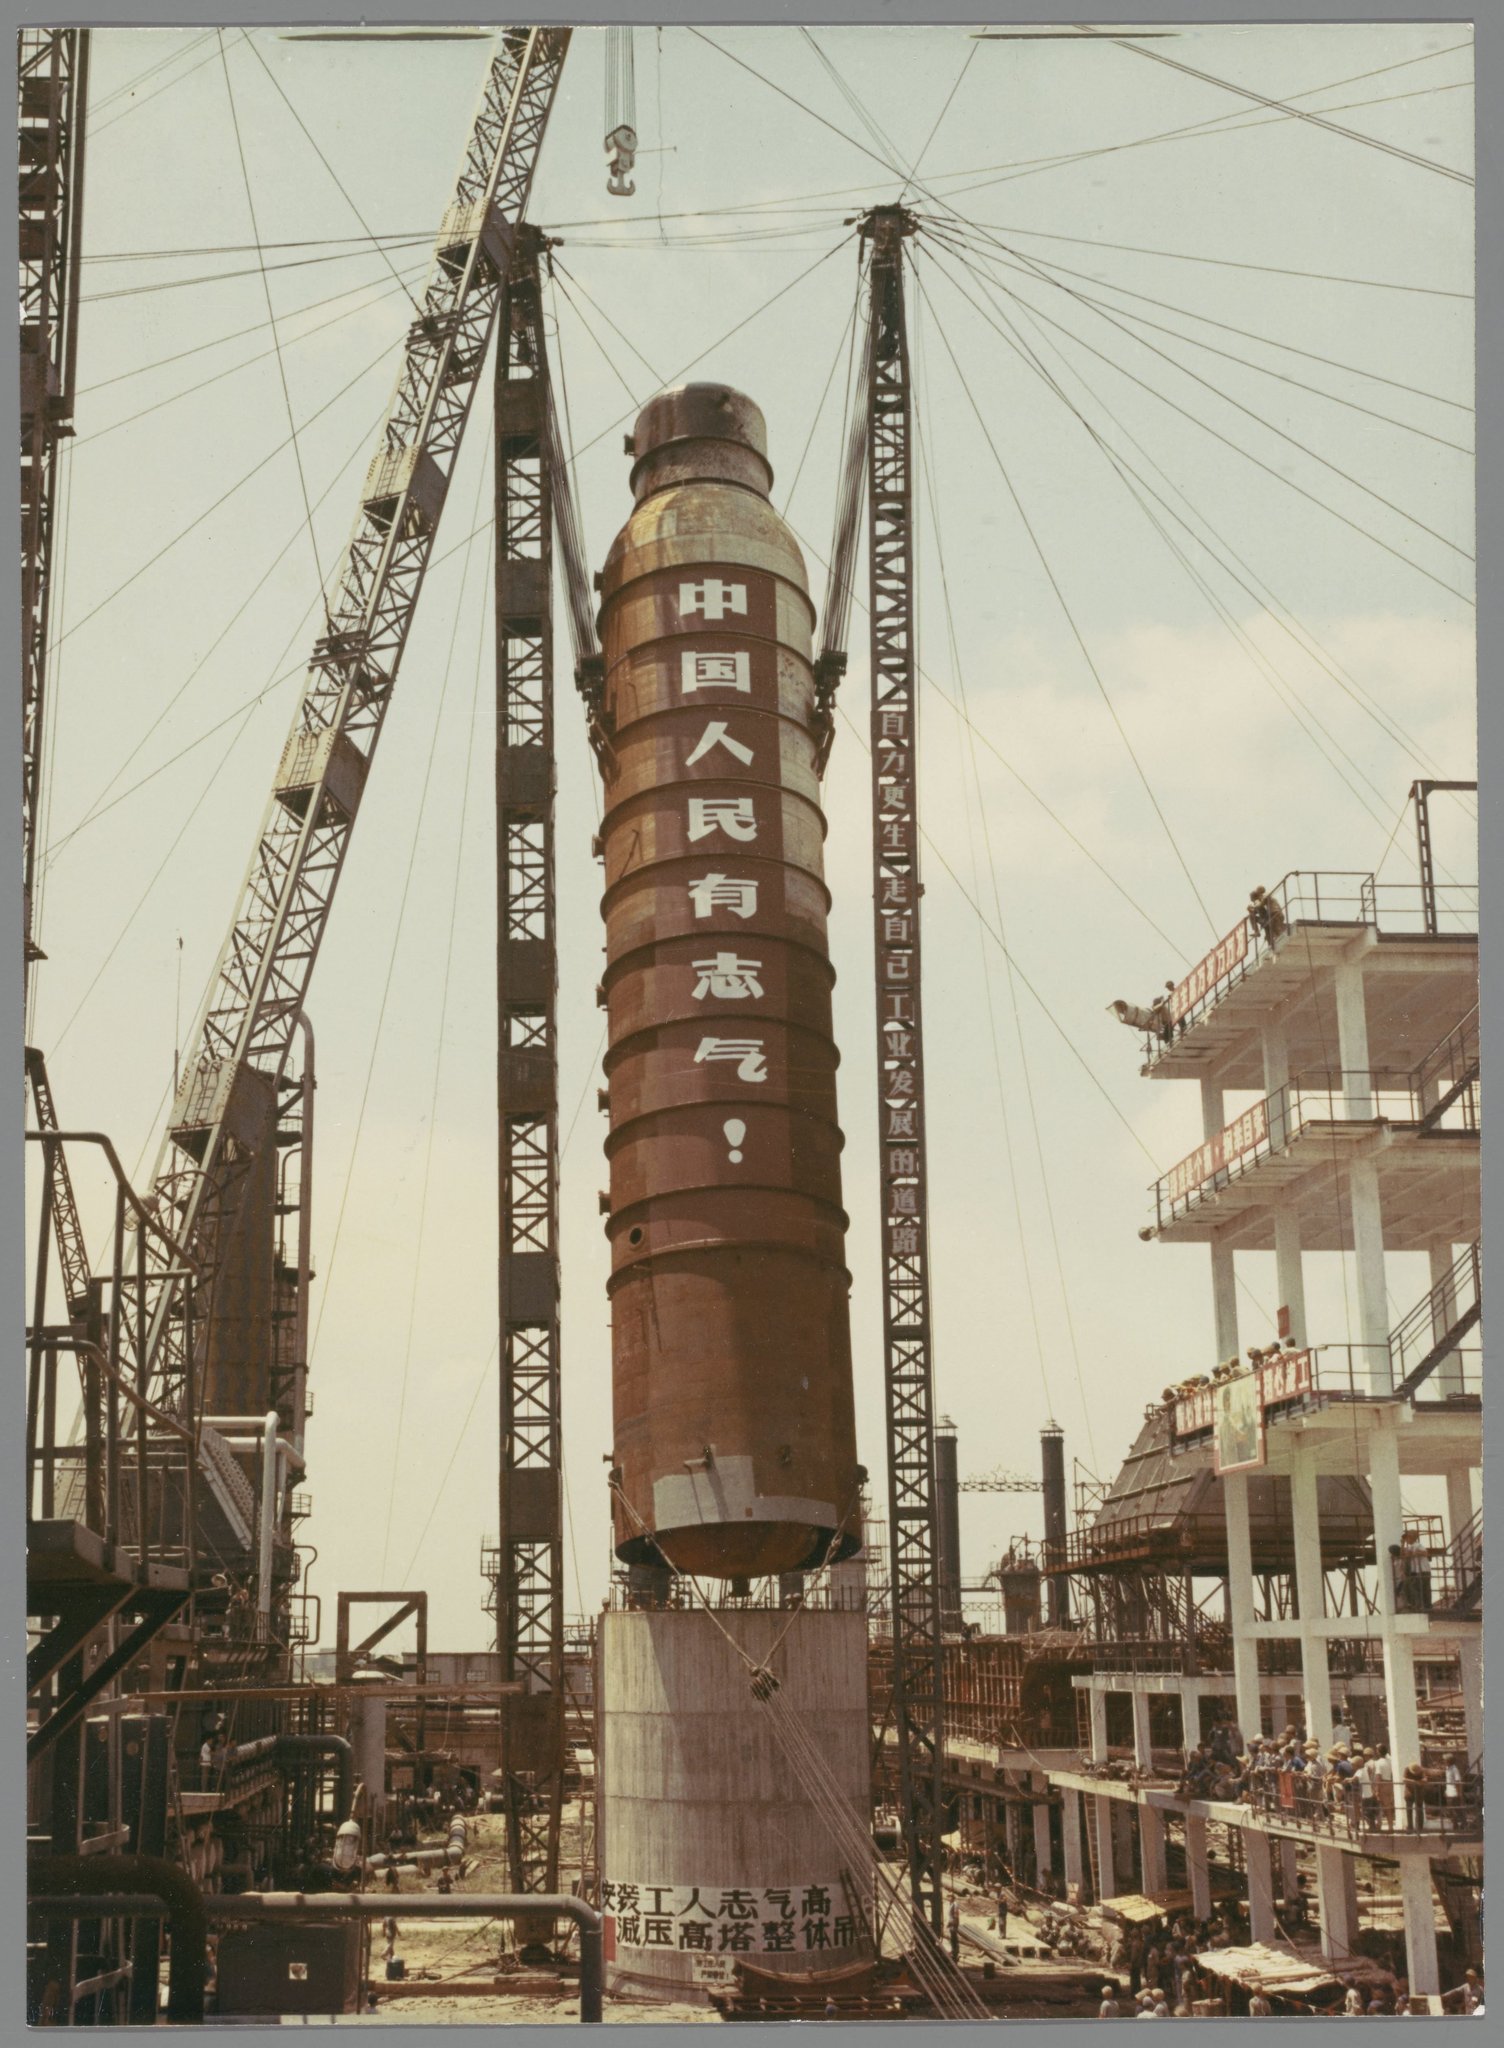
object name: photograph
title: Het plaatsen van een olieopslagtoren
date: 1970-1975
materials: photographic support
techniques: chromogenic print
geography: china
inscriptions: inscription: ‘Installing new equipment...’, stamp: ‘Copyright ANEFO Kerkstraat 310 AMsterdam-C’